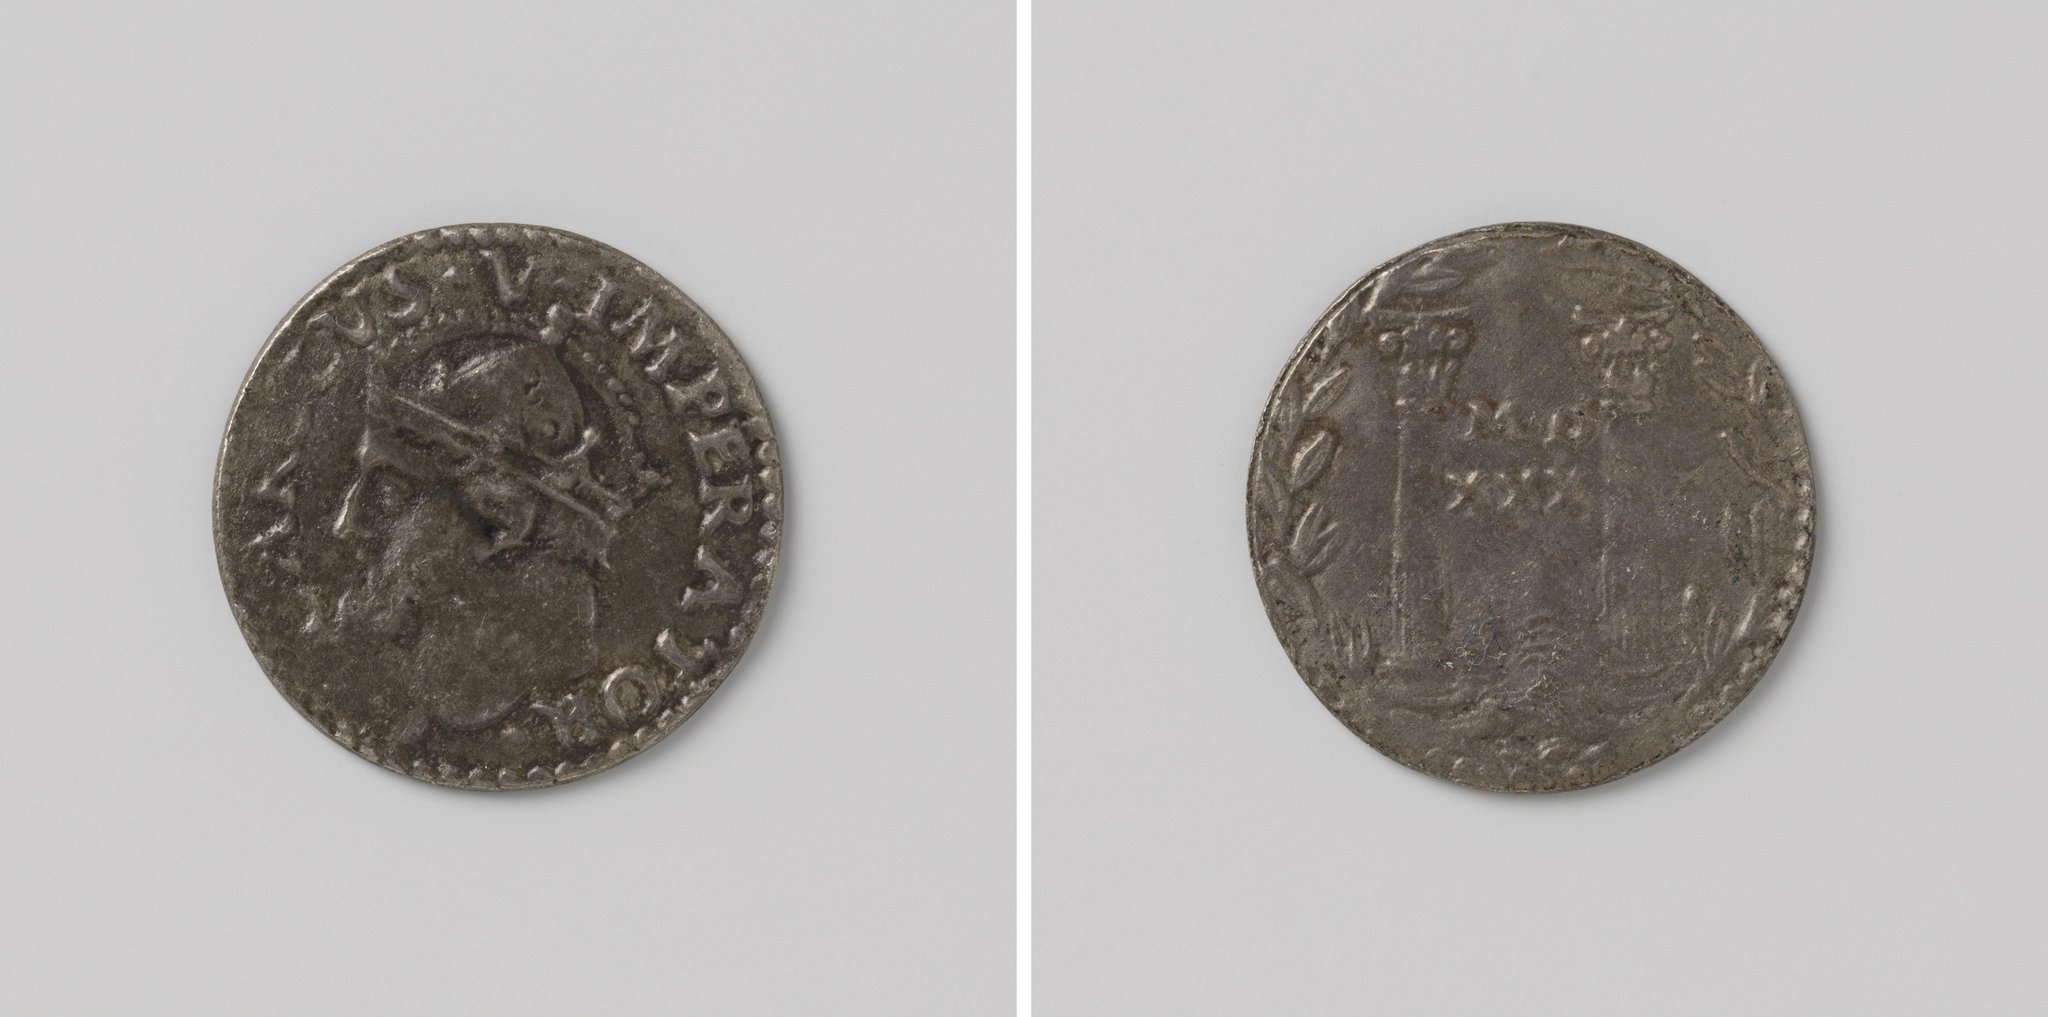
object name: strooipenning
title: Kroning van Karel V tot keizer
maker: Anonymous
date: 1530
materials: silver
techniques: striking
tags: charles v (holy roman emperor and king of spain)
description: Zilveren penning. Voorzijde: borststuk man met kroon binnen omschrift. Keerzijde: zuilen van Herkules met daartussen jaartal binnen lauwerkrans.